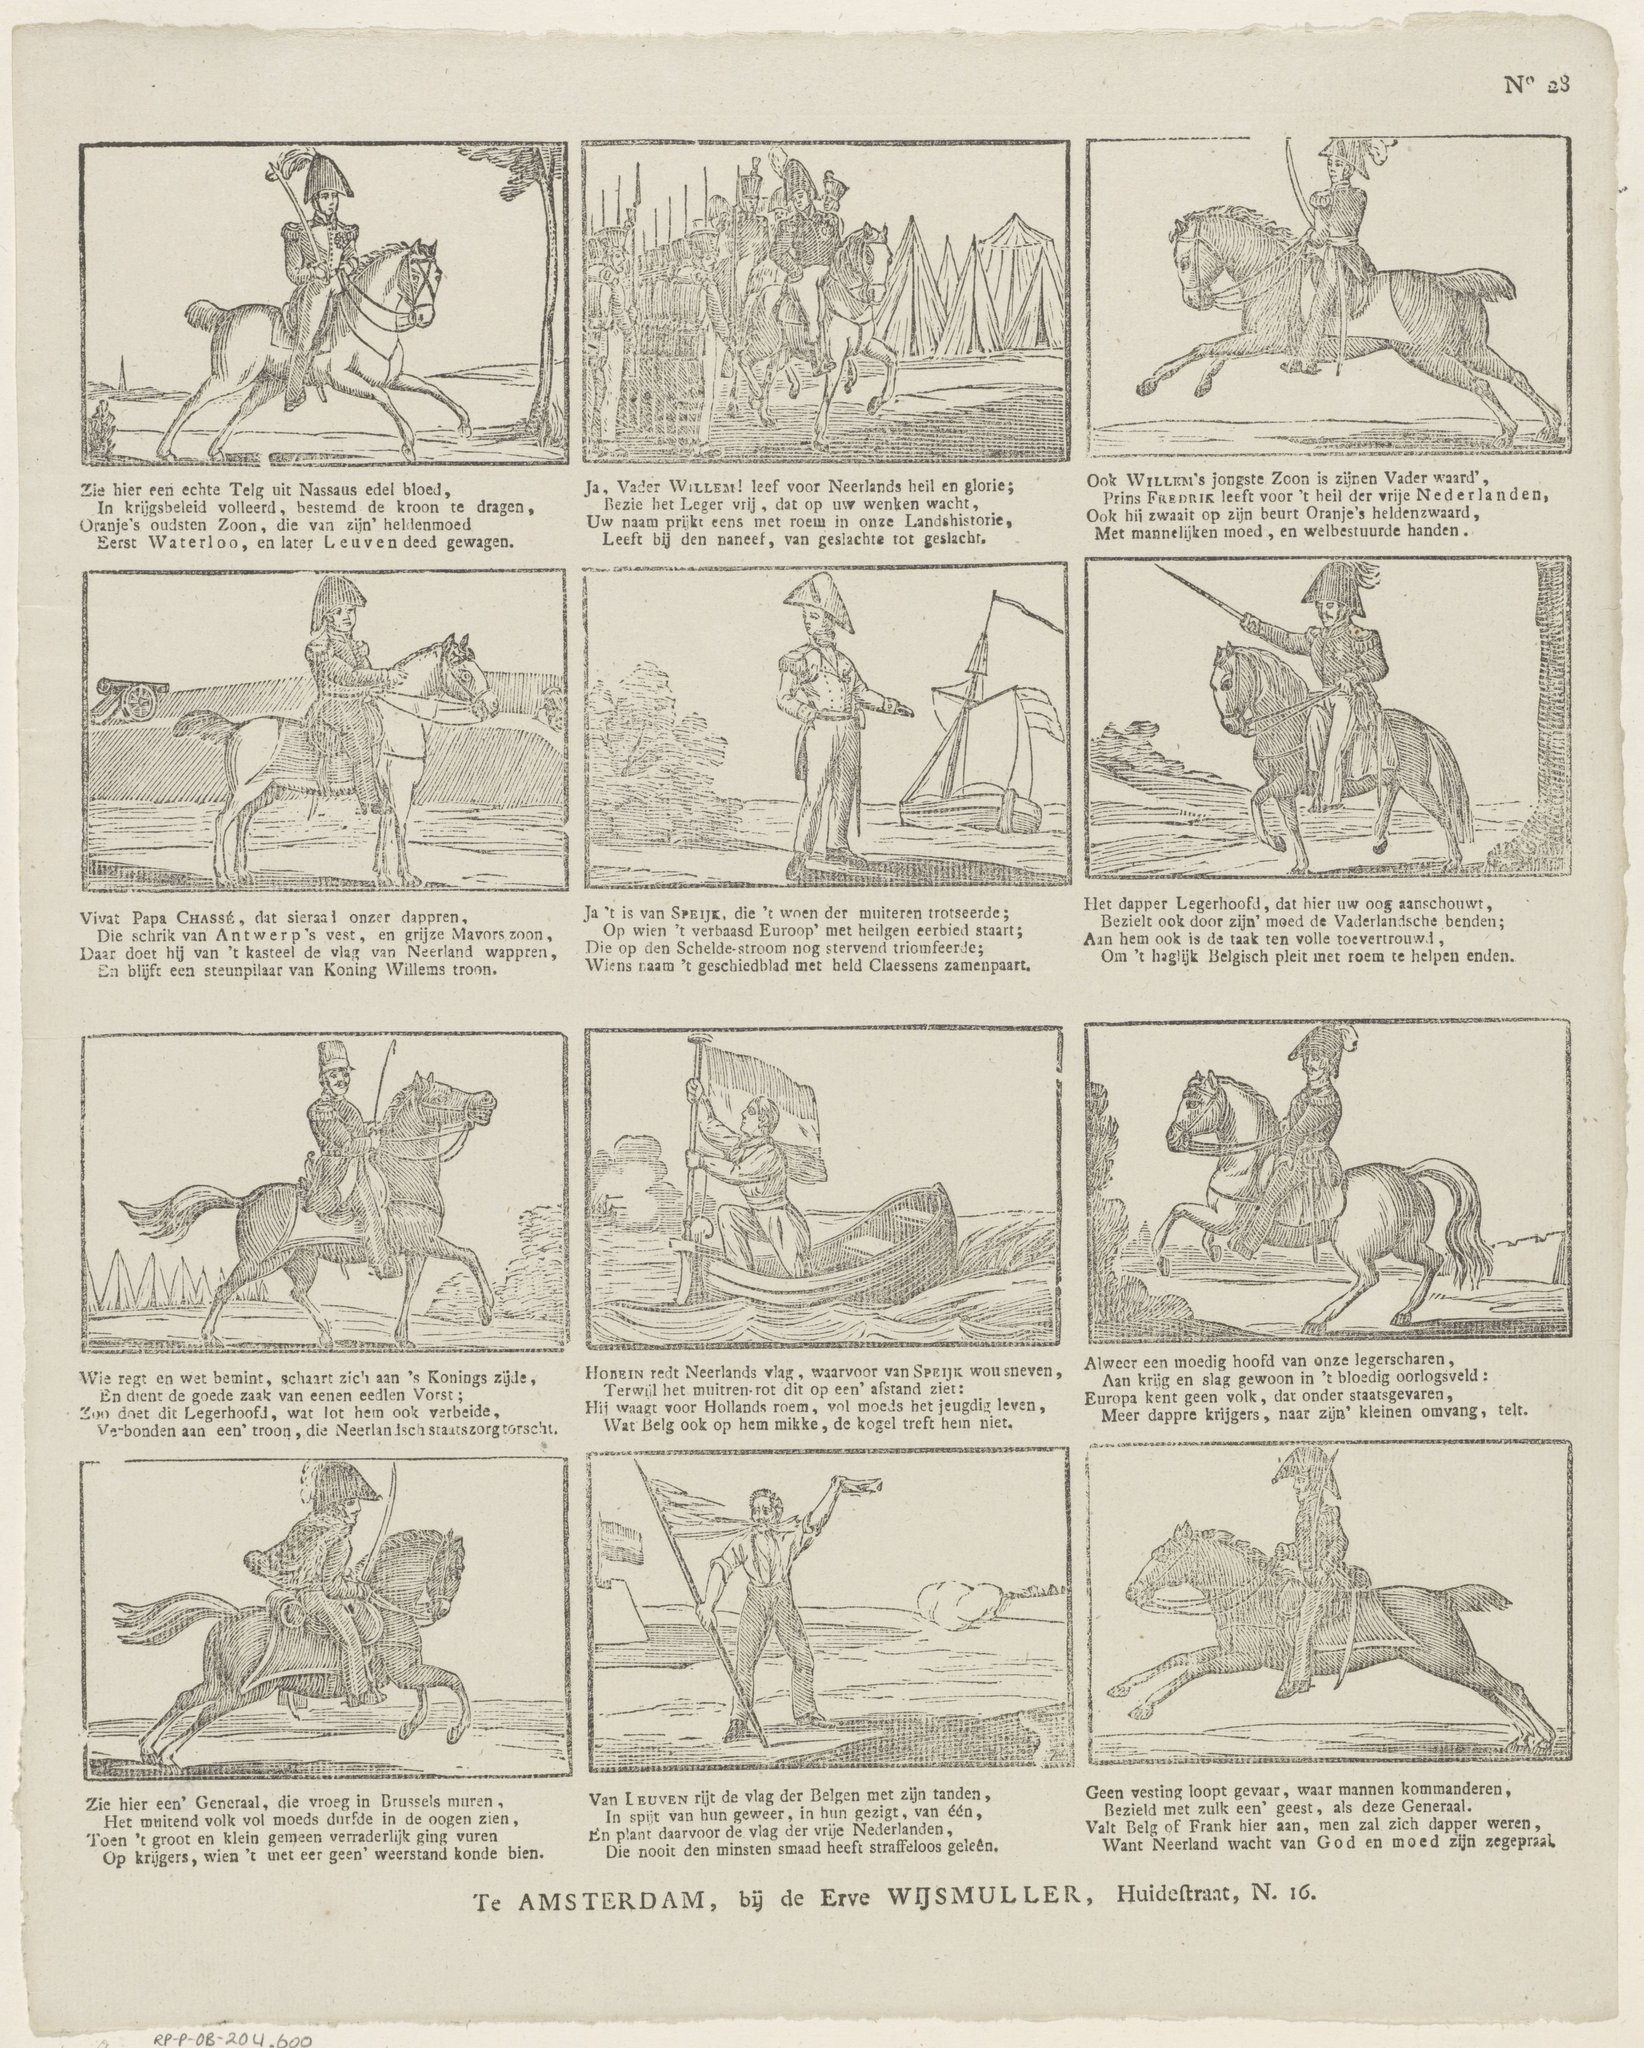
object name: popular print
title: Belgische Revolutie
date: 1828-1849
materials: paper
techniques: letterpress printing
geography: deventer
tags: amsterdam, antwerp, jan van speyk, william i of the netherlands, berlin, frederik (prins der nederlanden), battle, warfare; military affairs (+ cavalry, horsemen), the soldier; the soldier's life, netherlands, belgium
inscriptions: collector's mark: Lugt 2760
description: Blad met 12 voorstellingen over de Belgische Revolutie. Onder elke afbeelding een vierregelig vers. Genummerd rechtsboven: N. 28.